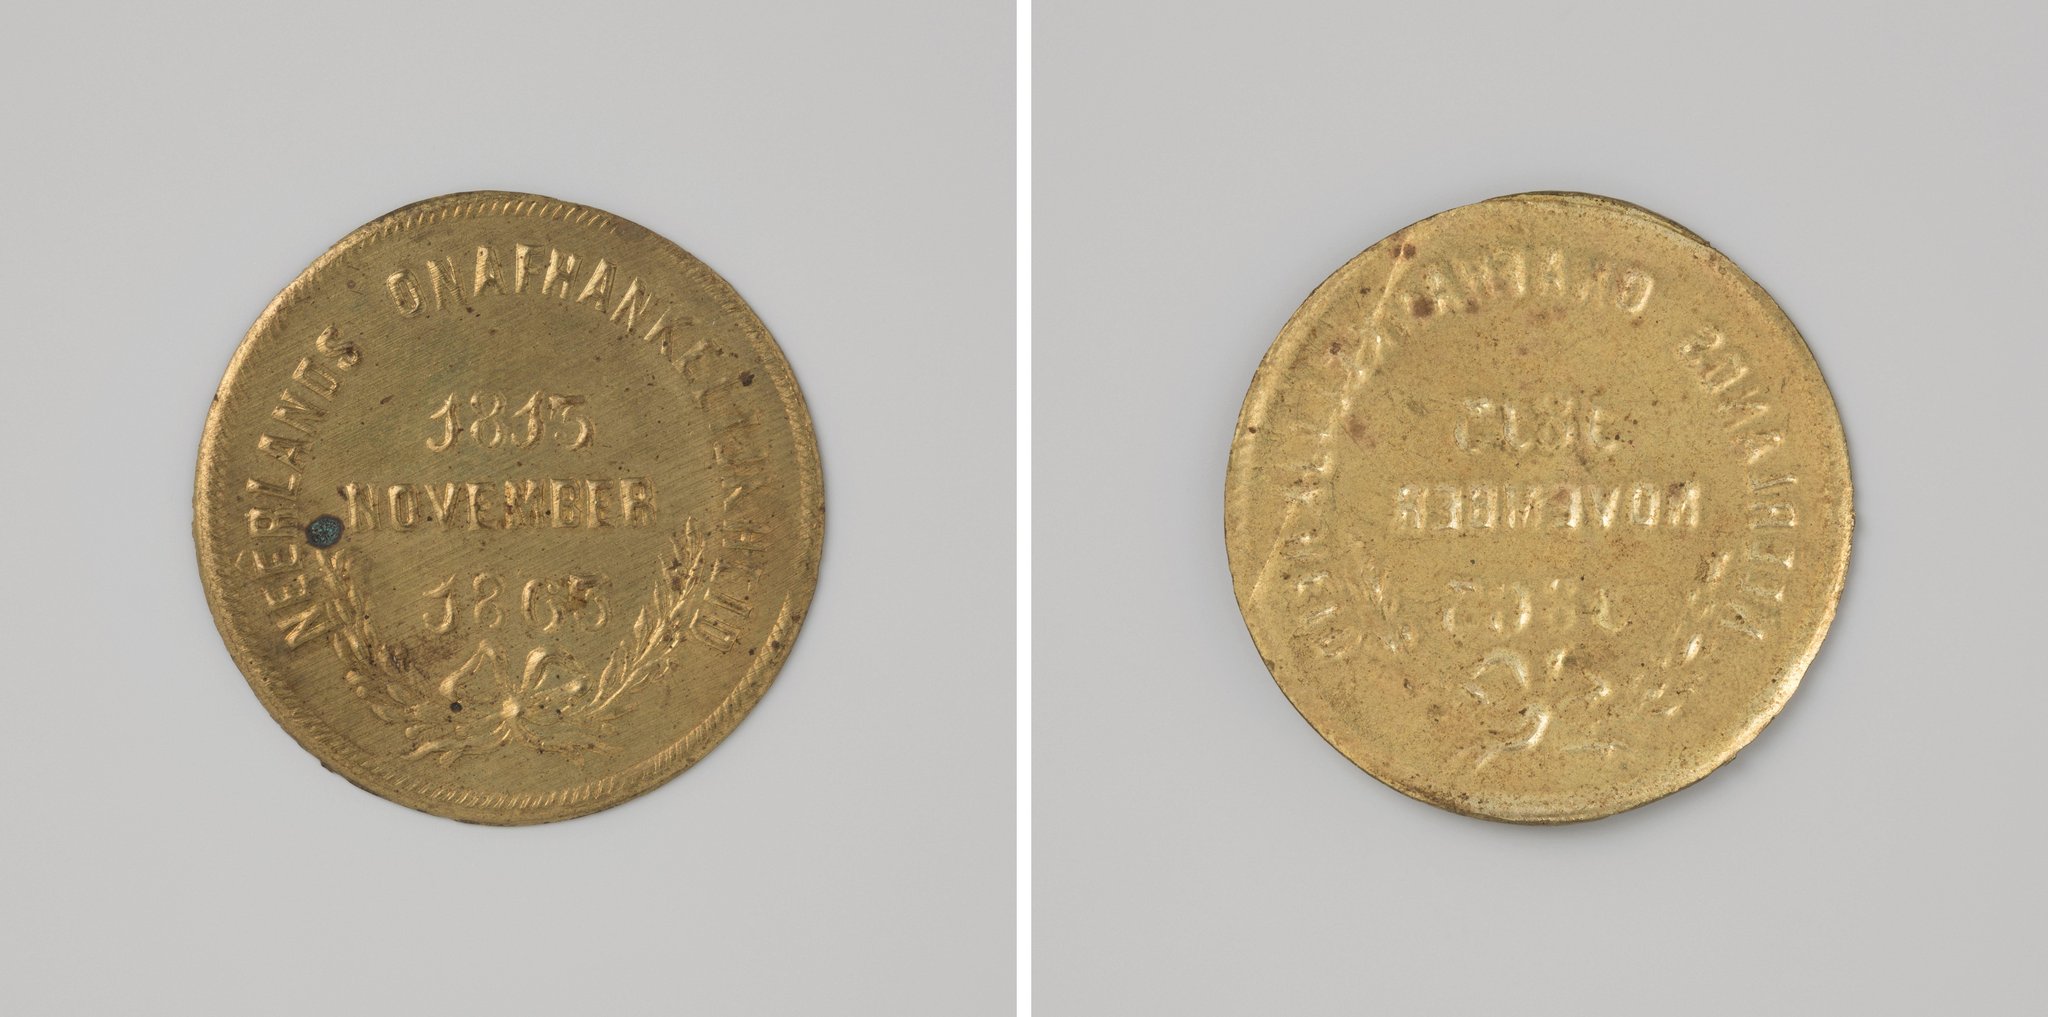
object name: history medal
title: Vijftigjarige herdenking van het herstel van de onafhankelijkheid 1865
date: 1863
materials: brass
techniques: pressing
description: Ronde applique van messingblik met drie regels tekst tussen samengestrikte lauwertakken, met omschrift.